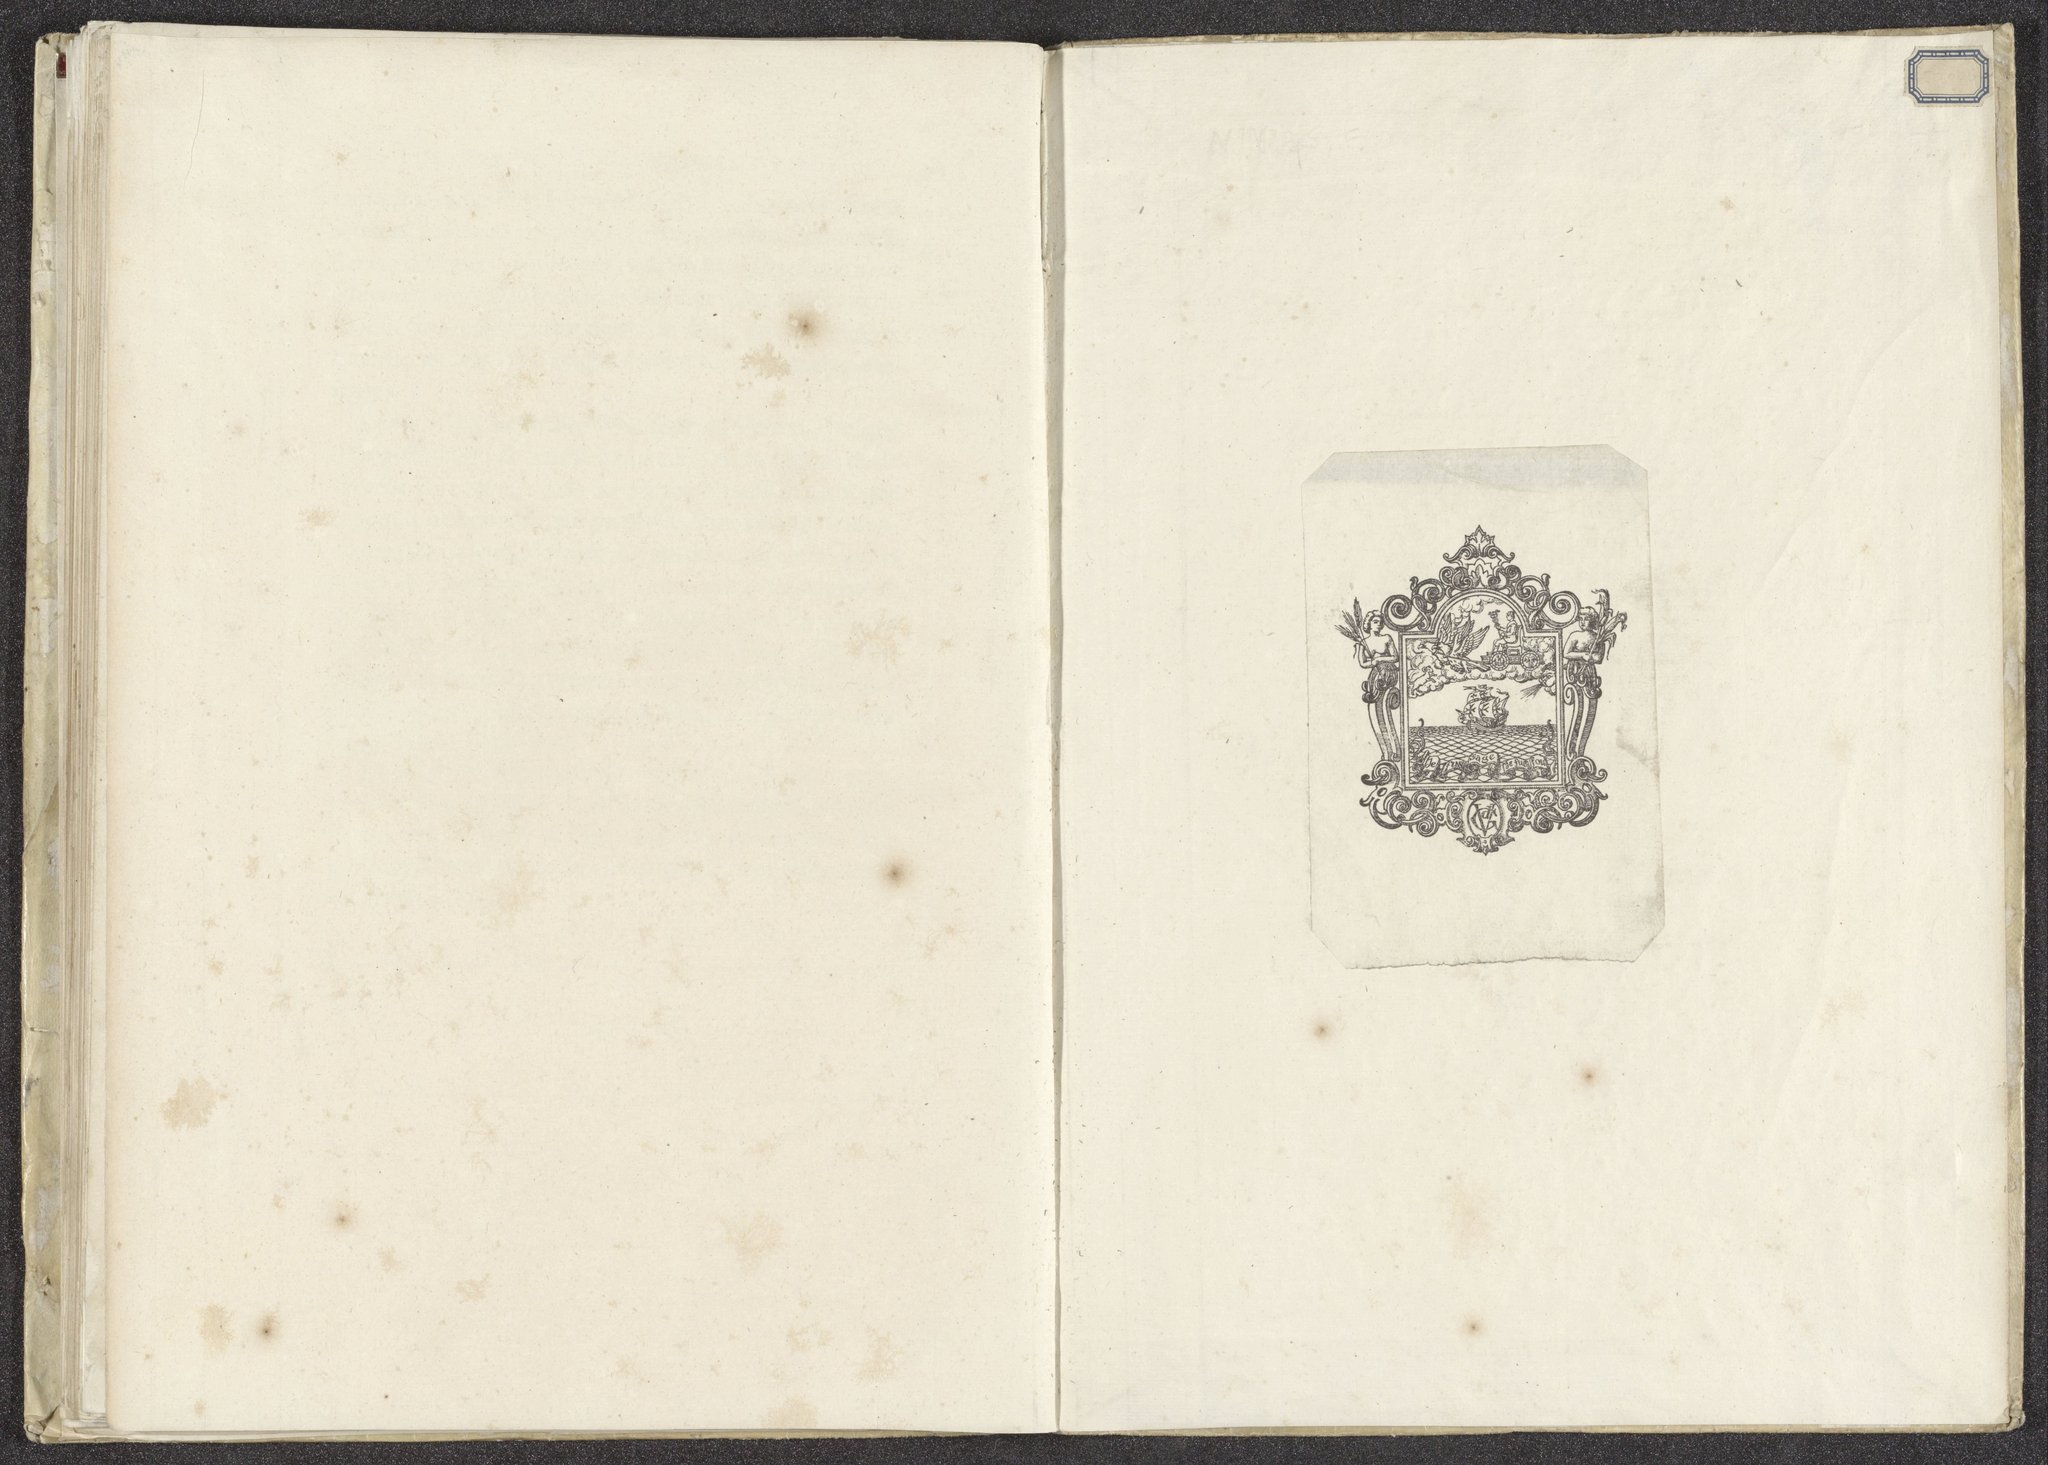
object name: bookplate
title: Ex libris van Ludovico de Gobbis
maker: alberto zanverdiani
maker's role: print maker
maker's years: 1894-1977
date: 1904-1977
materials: paper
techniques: woodcut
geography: venice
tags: (story of) mercury (hermes), ex-libris, ships (in general)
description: Cartouche met een schip en Mercurius in een strijdwagen getrokken door twee adelaars. Daarbij een banderol met het motto: Je fus sage je fus fou. Het geheel in een ornamentele rand met links een man met drie korenhalmen en rechts een man met twee maïsstengels. Onderaan het monogram VdG. De ex-libris is geplakt in een boek over de ontvangst van de Franse koning-moeder Maria de' Medici aan Engeland.